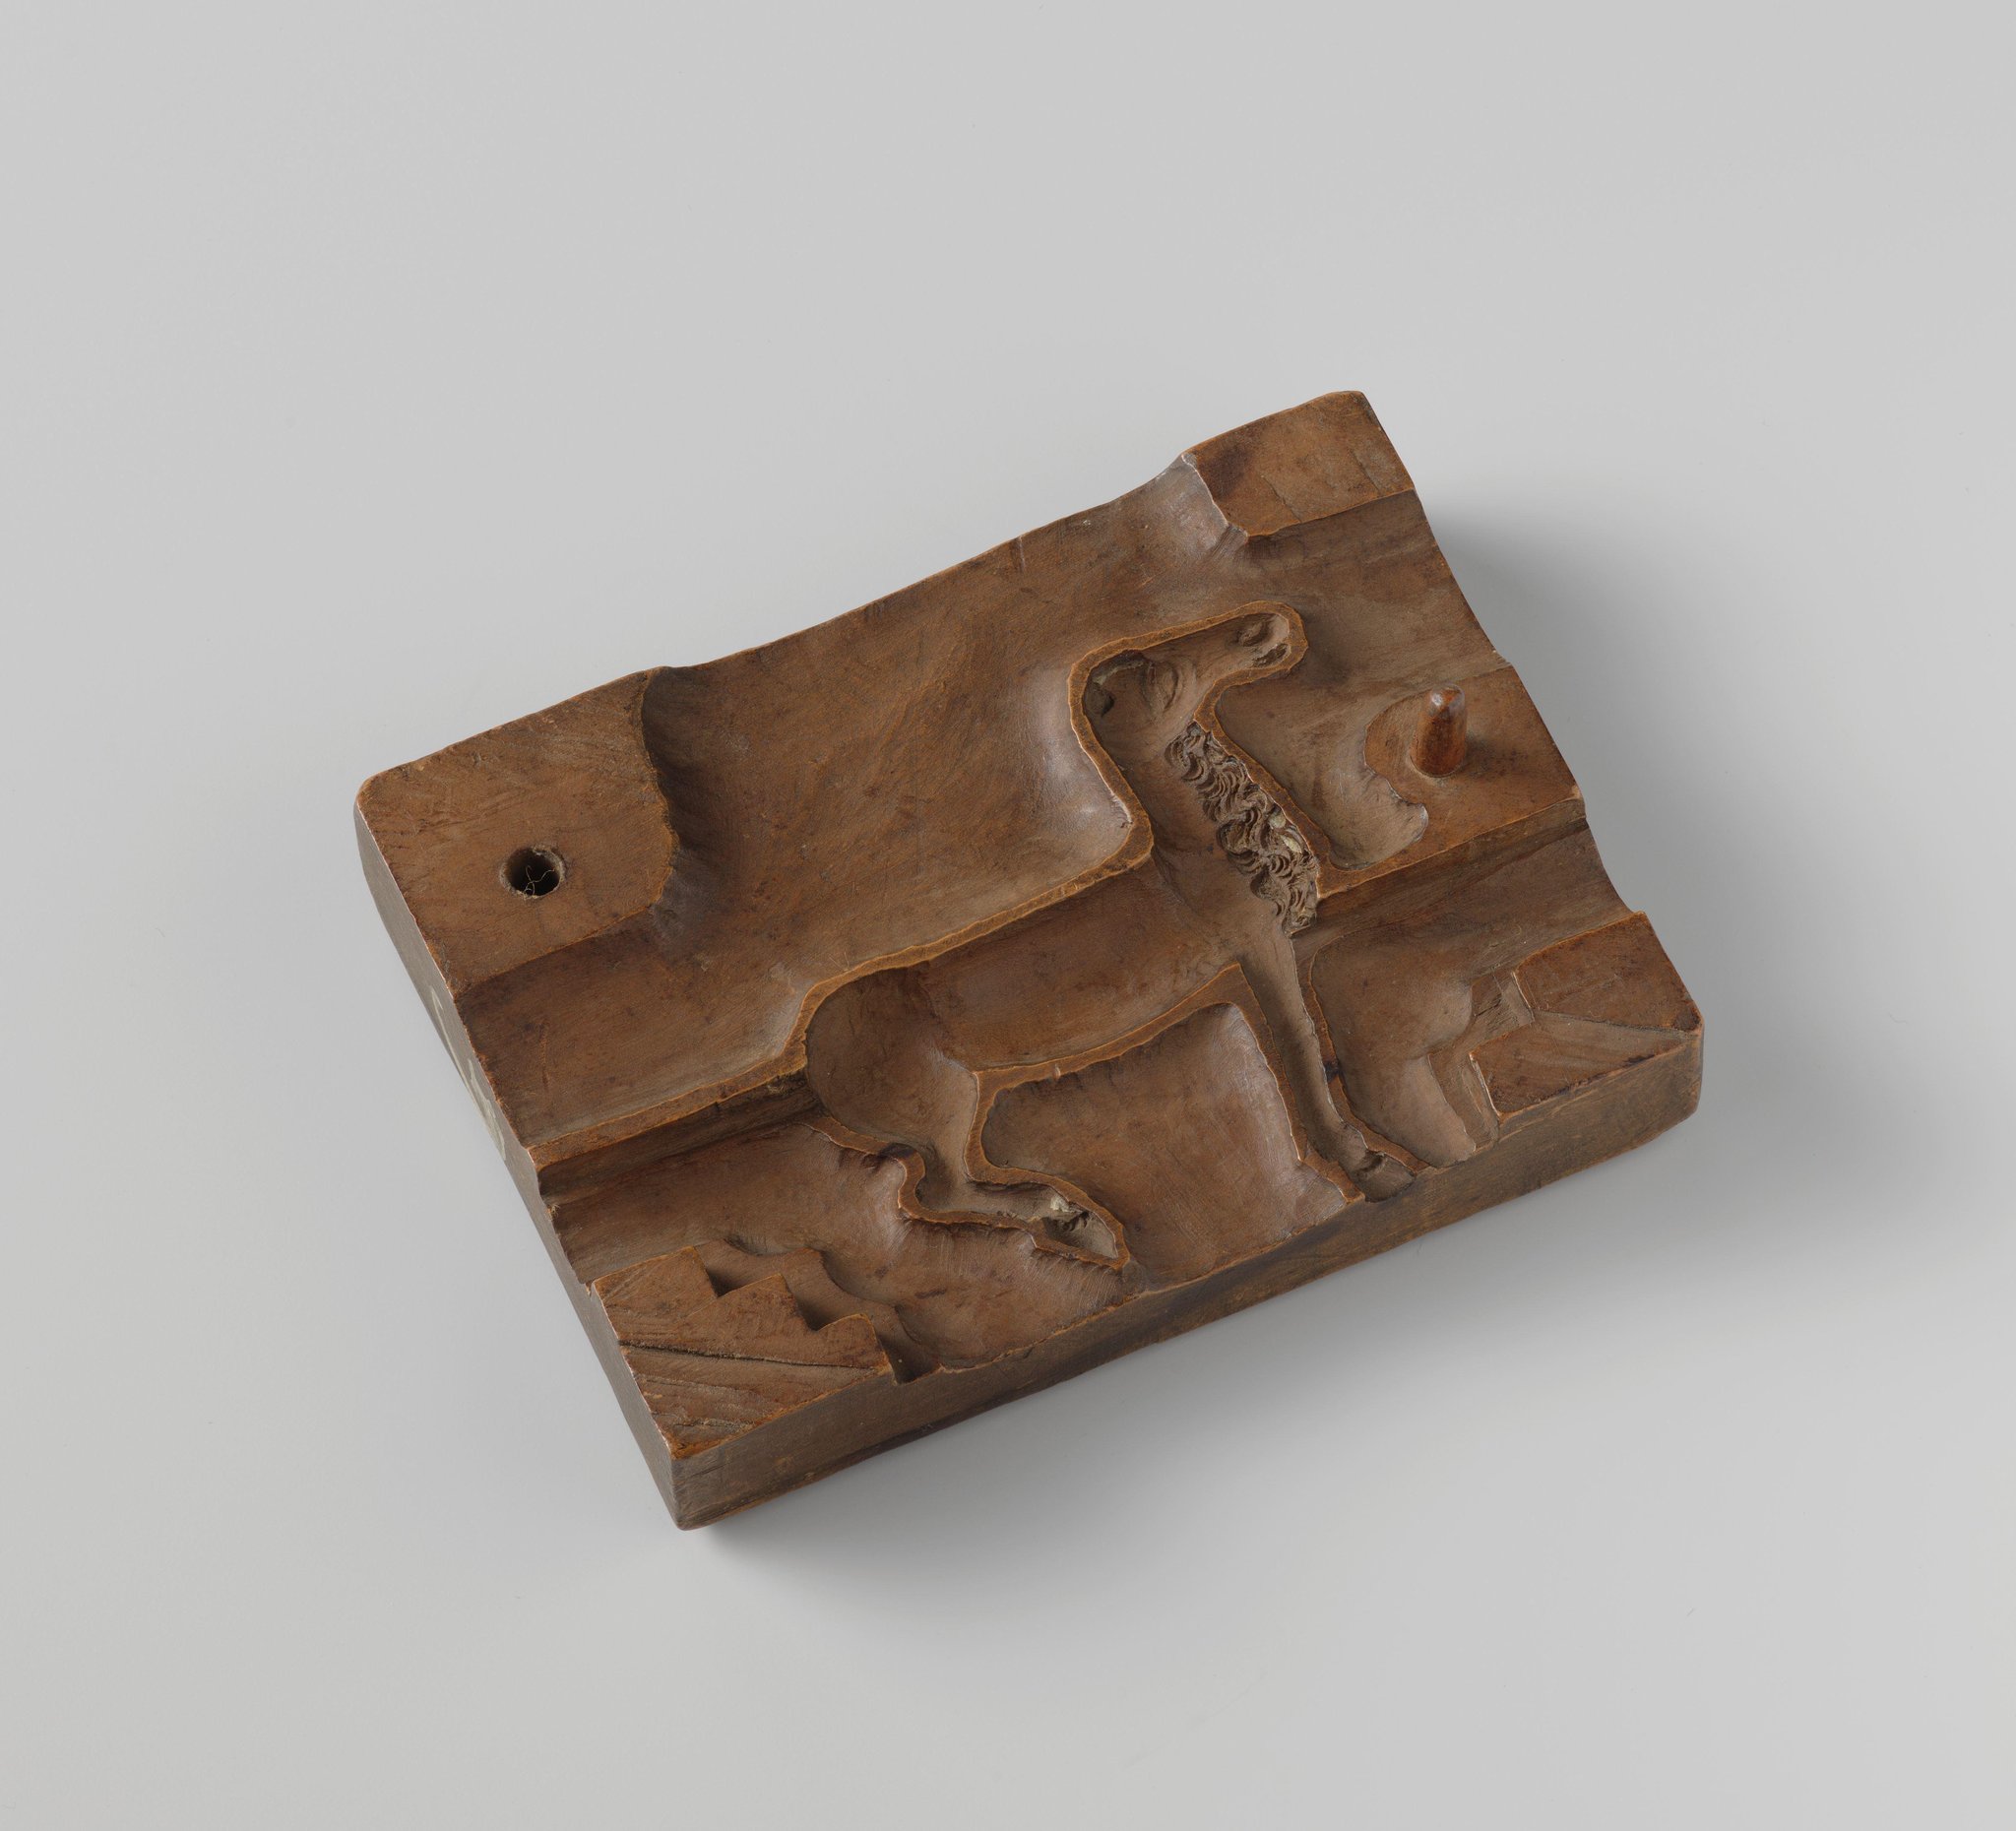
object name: bakvorm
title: Suikergoedvorm van perenhout in de vorm van een paard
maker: Anonymous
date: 1800-1900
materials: wood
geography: netherlands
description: Suikergoedvorm van perenhout in de vorm van een paard.